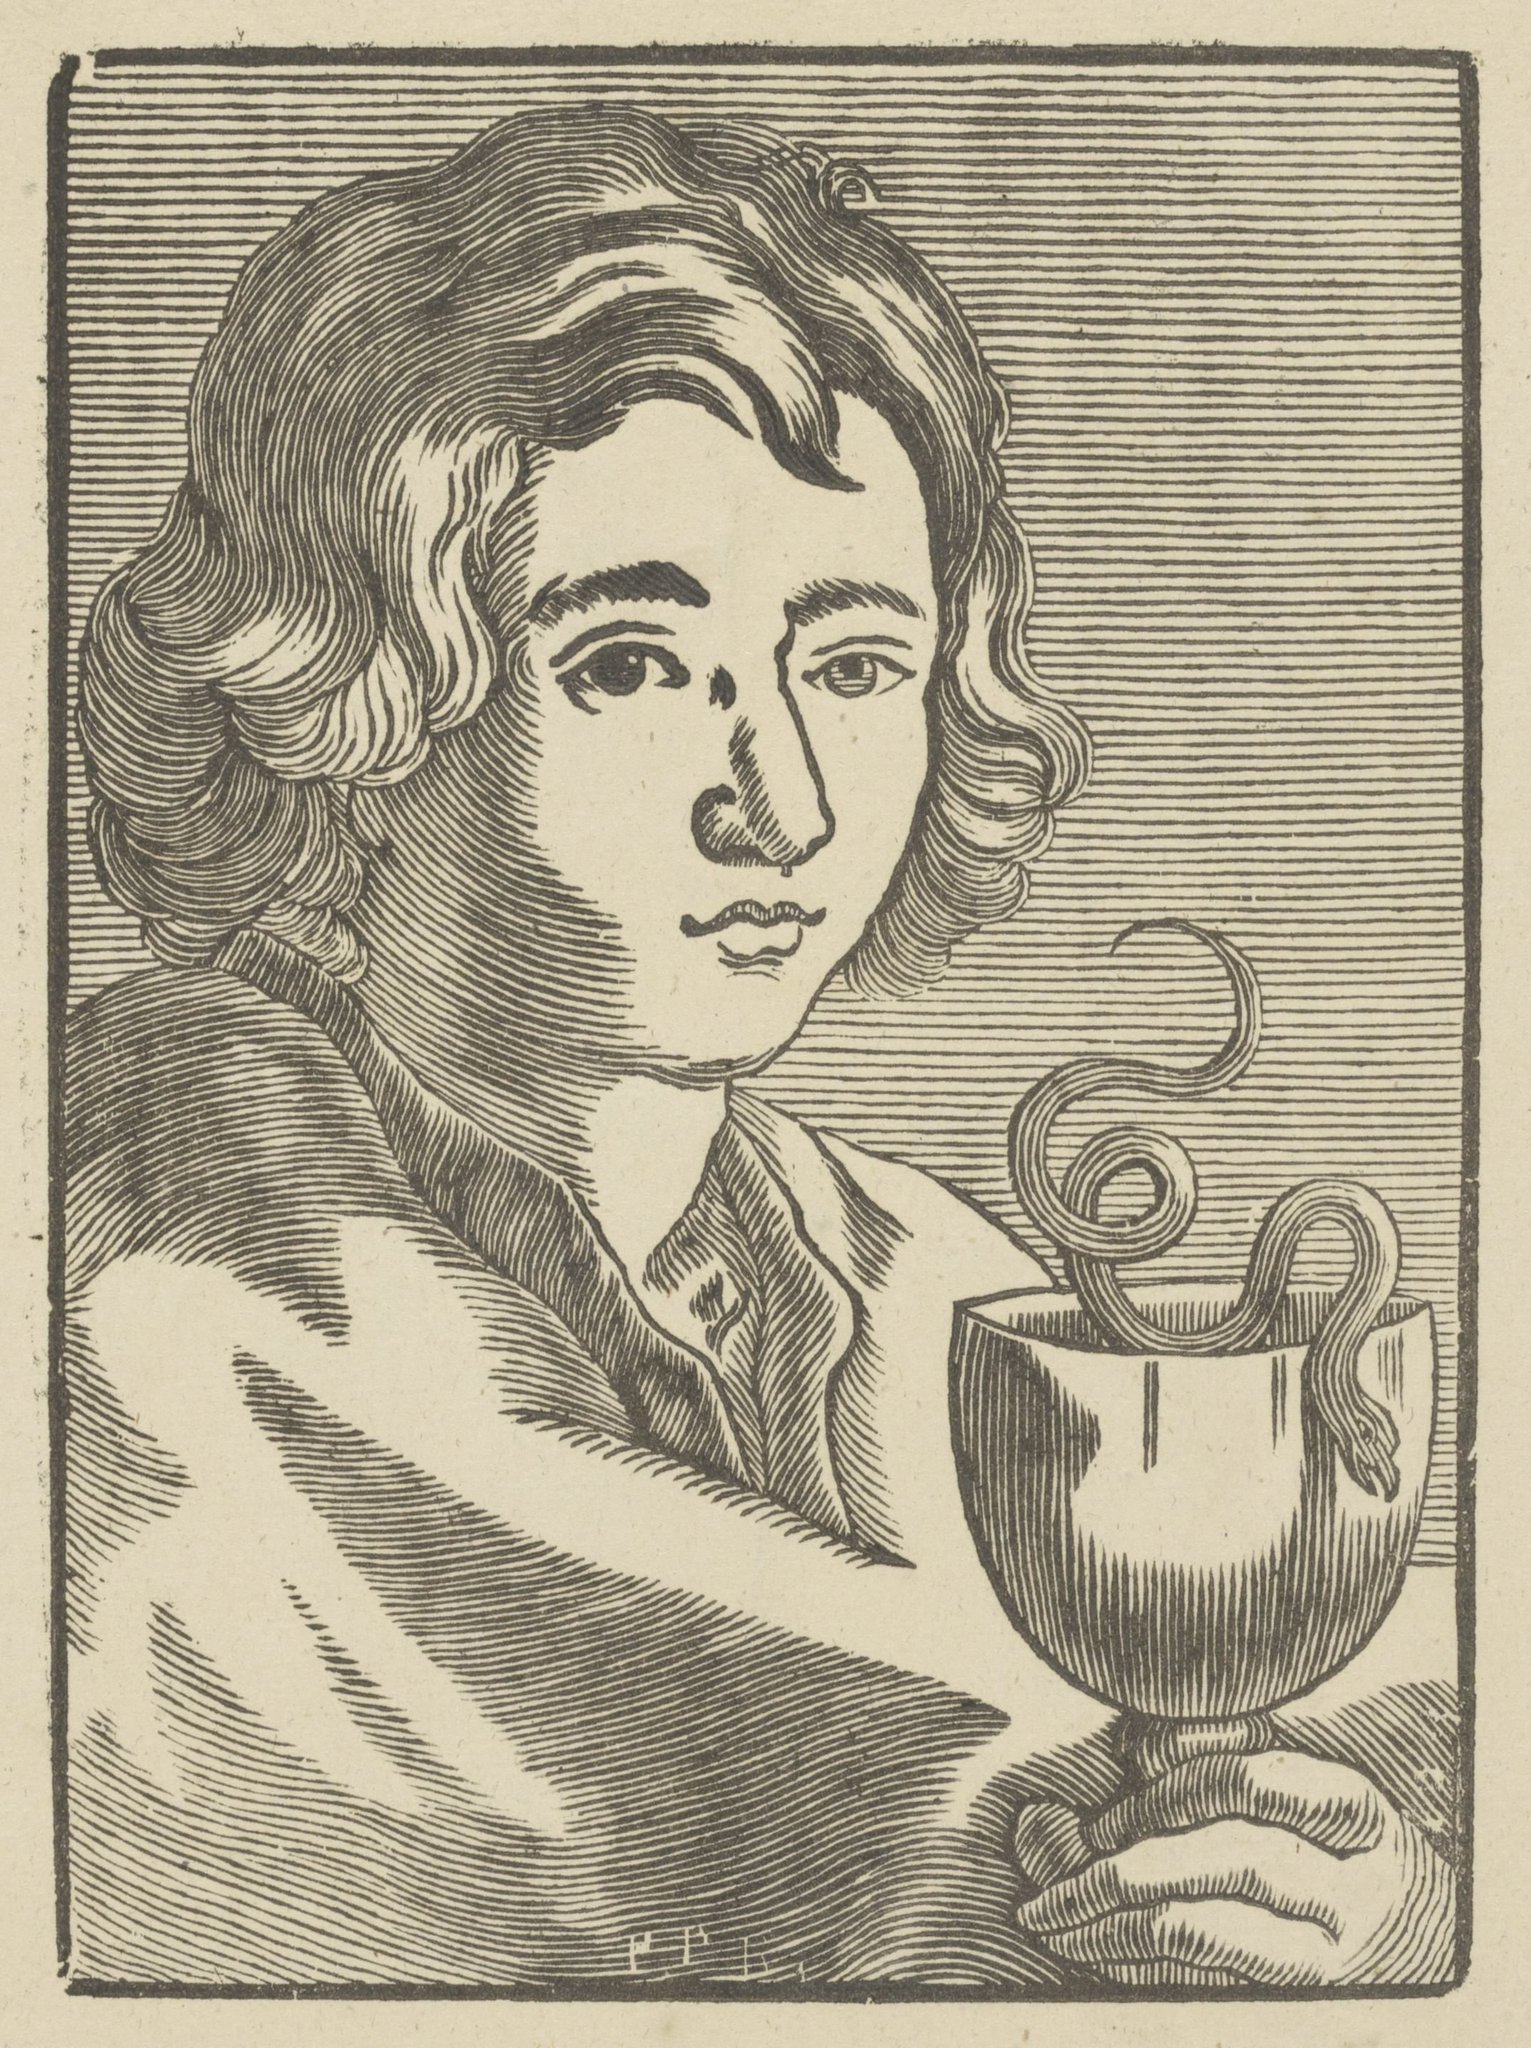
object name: print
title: Johannes de evangelist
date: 1600-1699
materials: paper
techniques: woodcut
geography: netherlands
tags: the apostle john the evangelist; possible attributes: book, cauldron, chalice with snake, eagle, palm, scroll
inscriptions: collector's mark: Lugt 240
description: Jongeman met een beker waaruit een adder kronkelt.